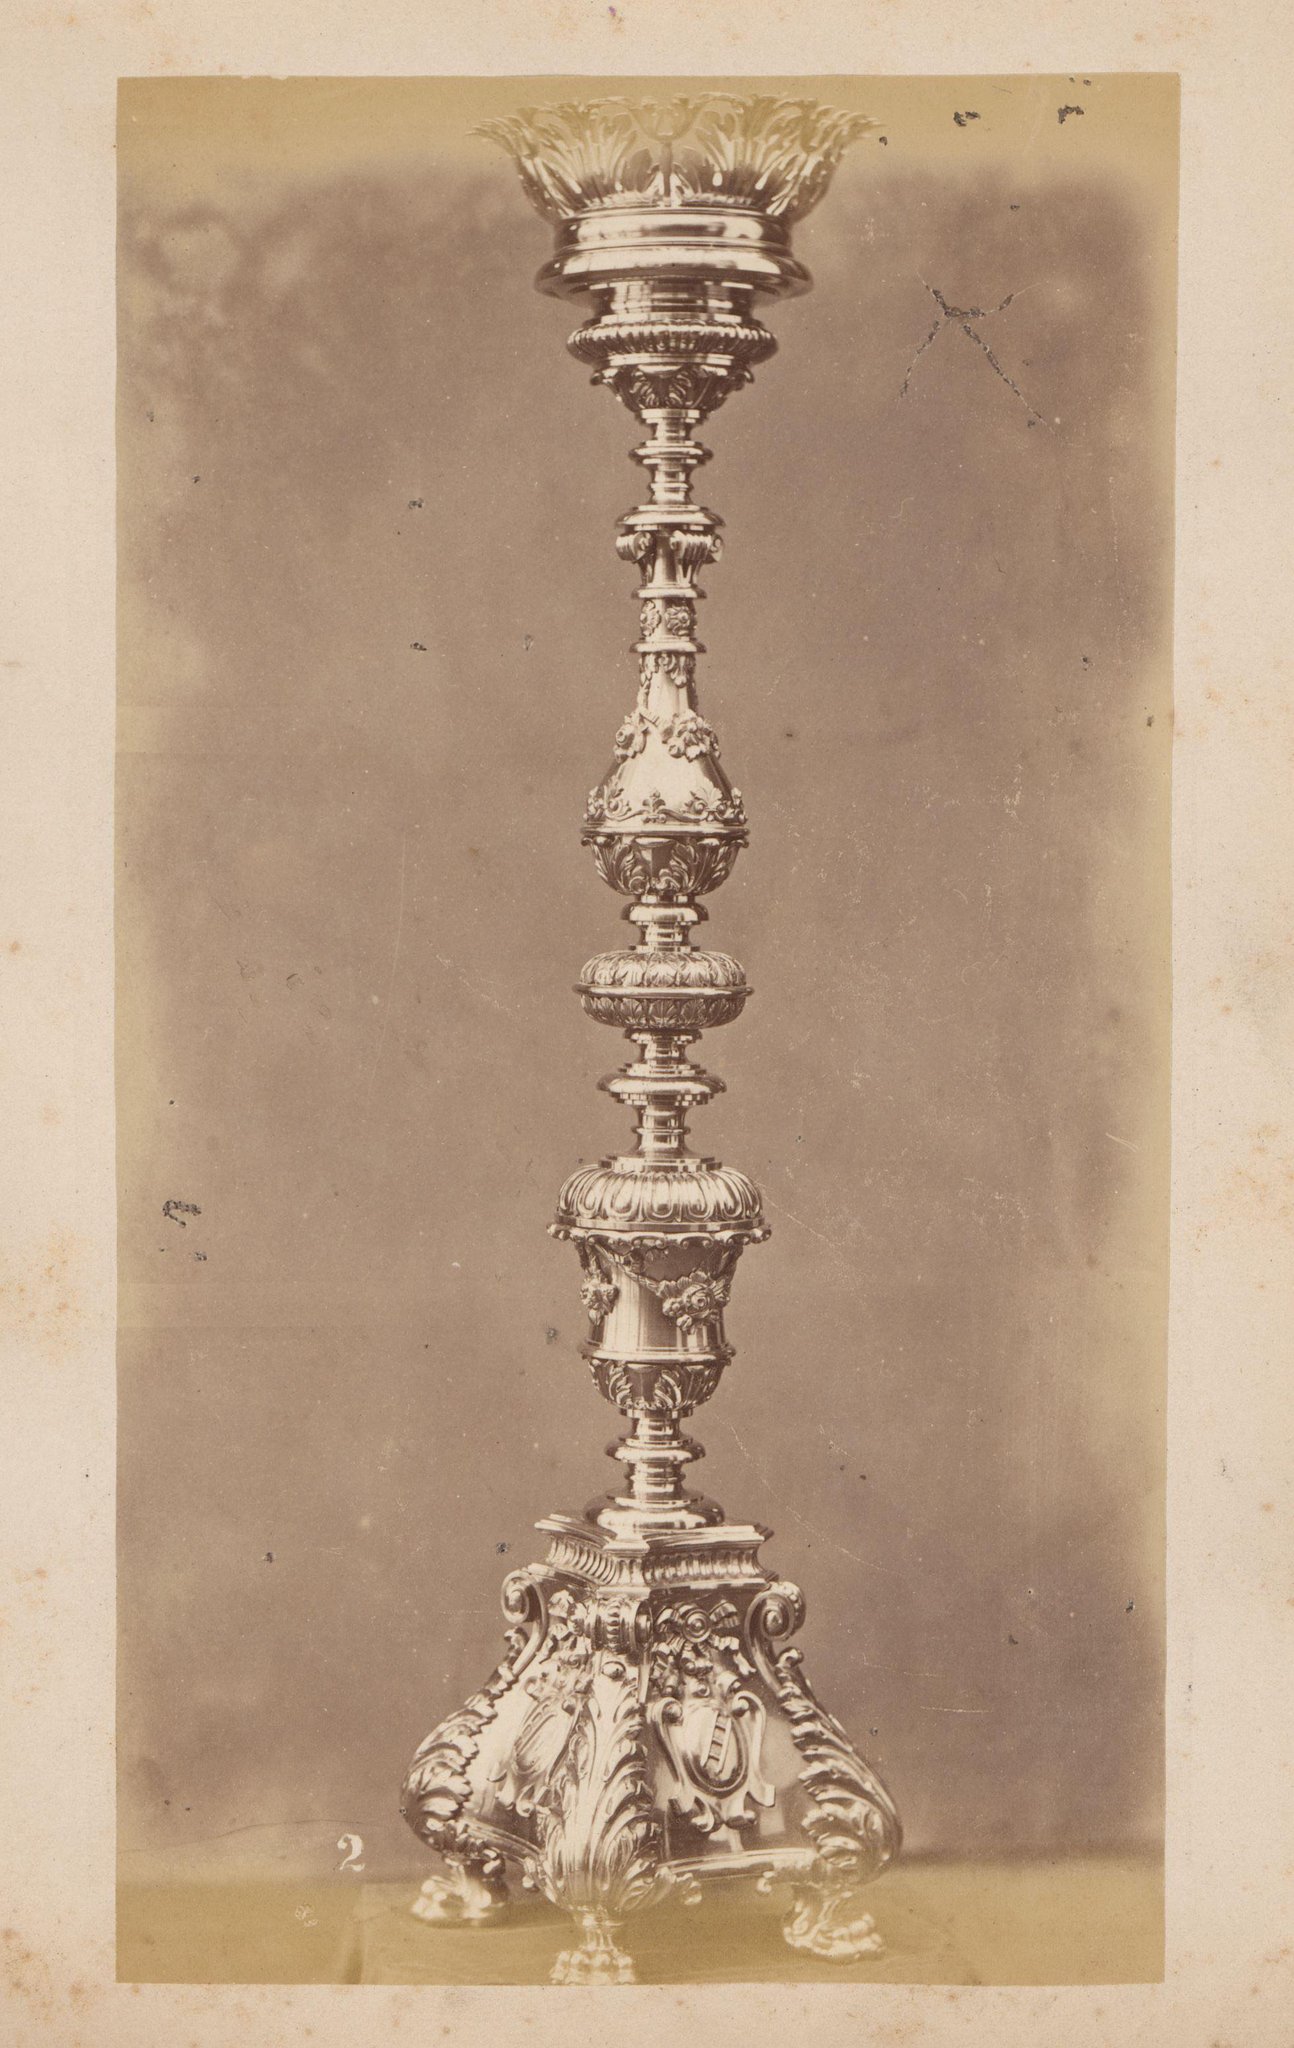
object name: page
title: Reuzenkandelaar voor gas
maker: Anonymous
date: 1860-1885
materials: photographic support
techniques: albumen print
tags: candlestick